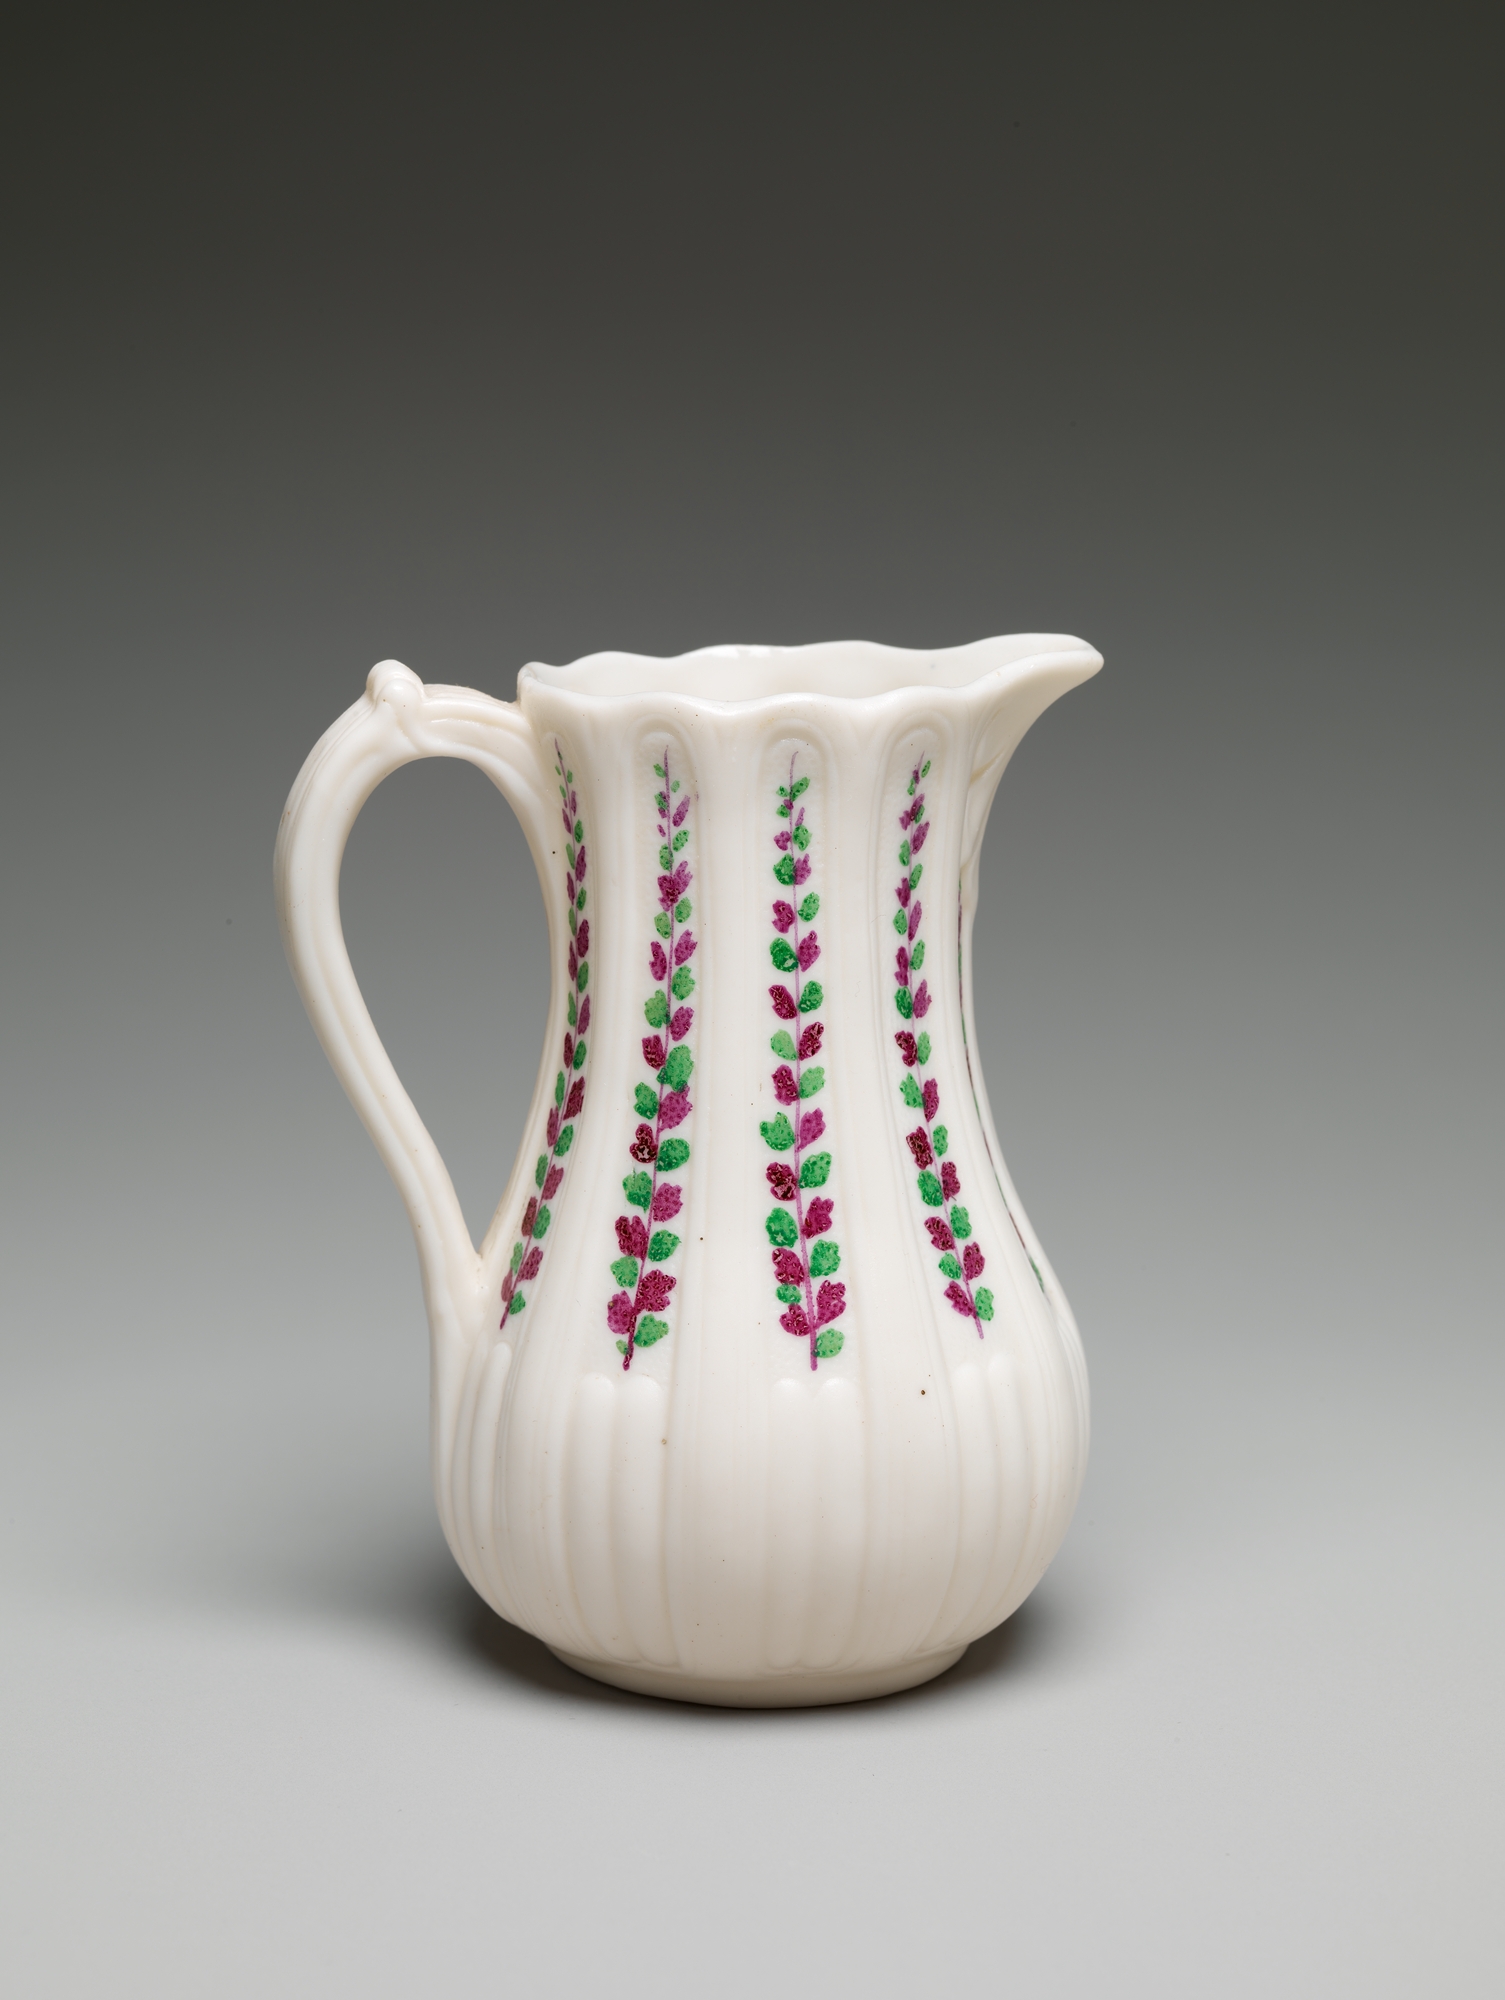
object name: pitcher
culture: american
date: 1830-1870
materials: porcelain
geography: united states